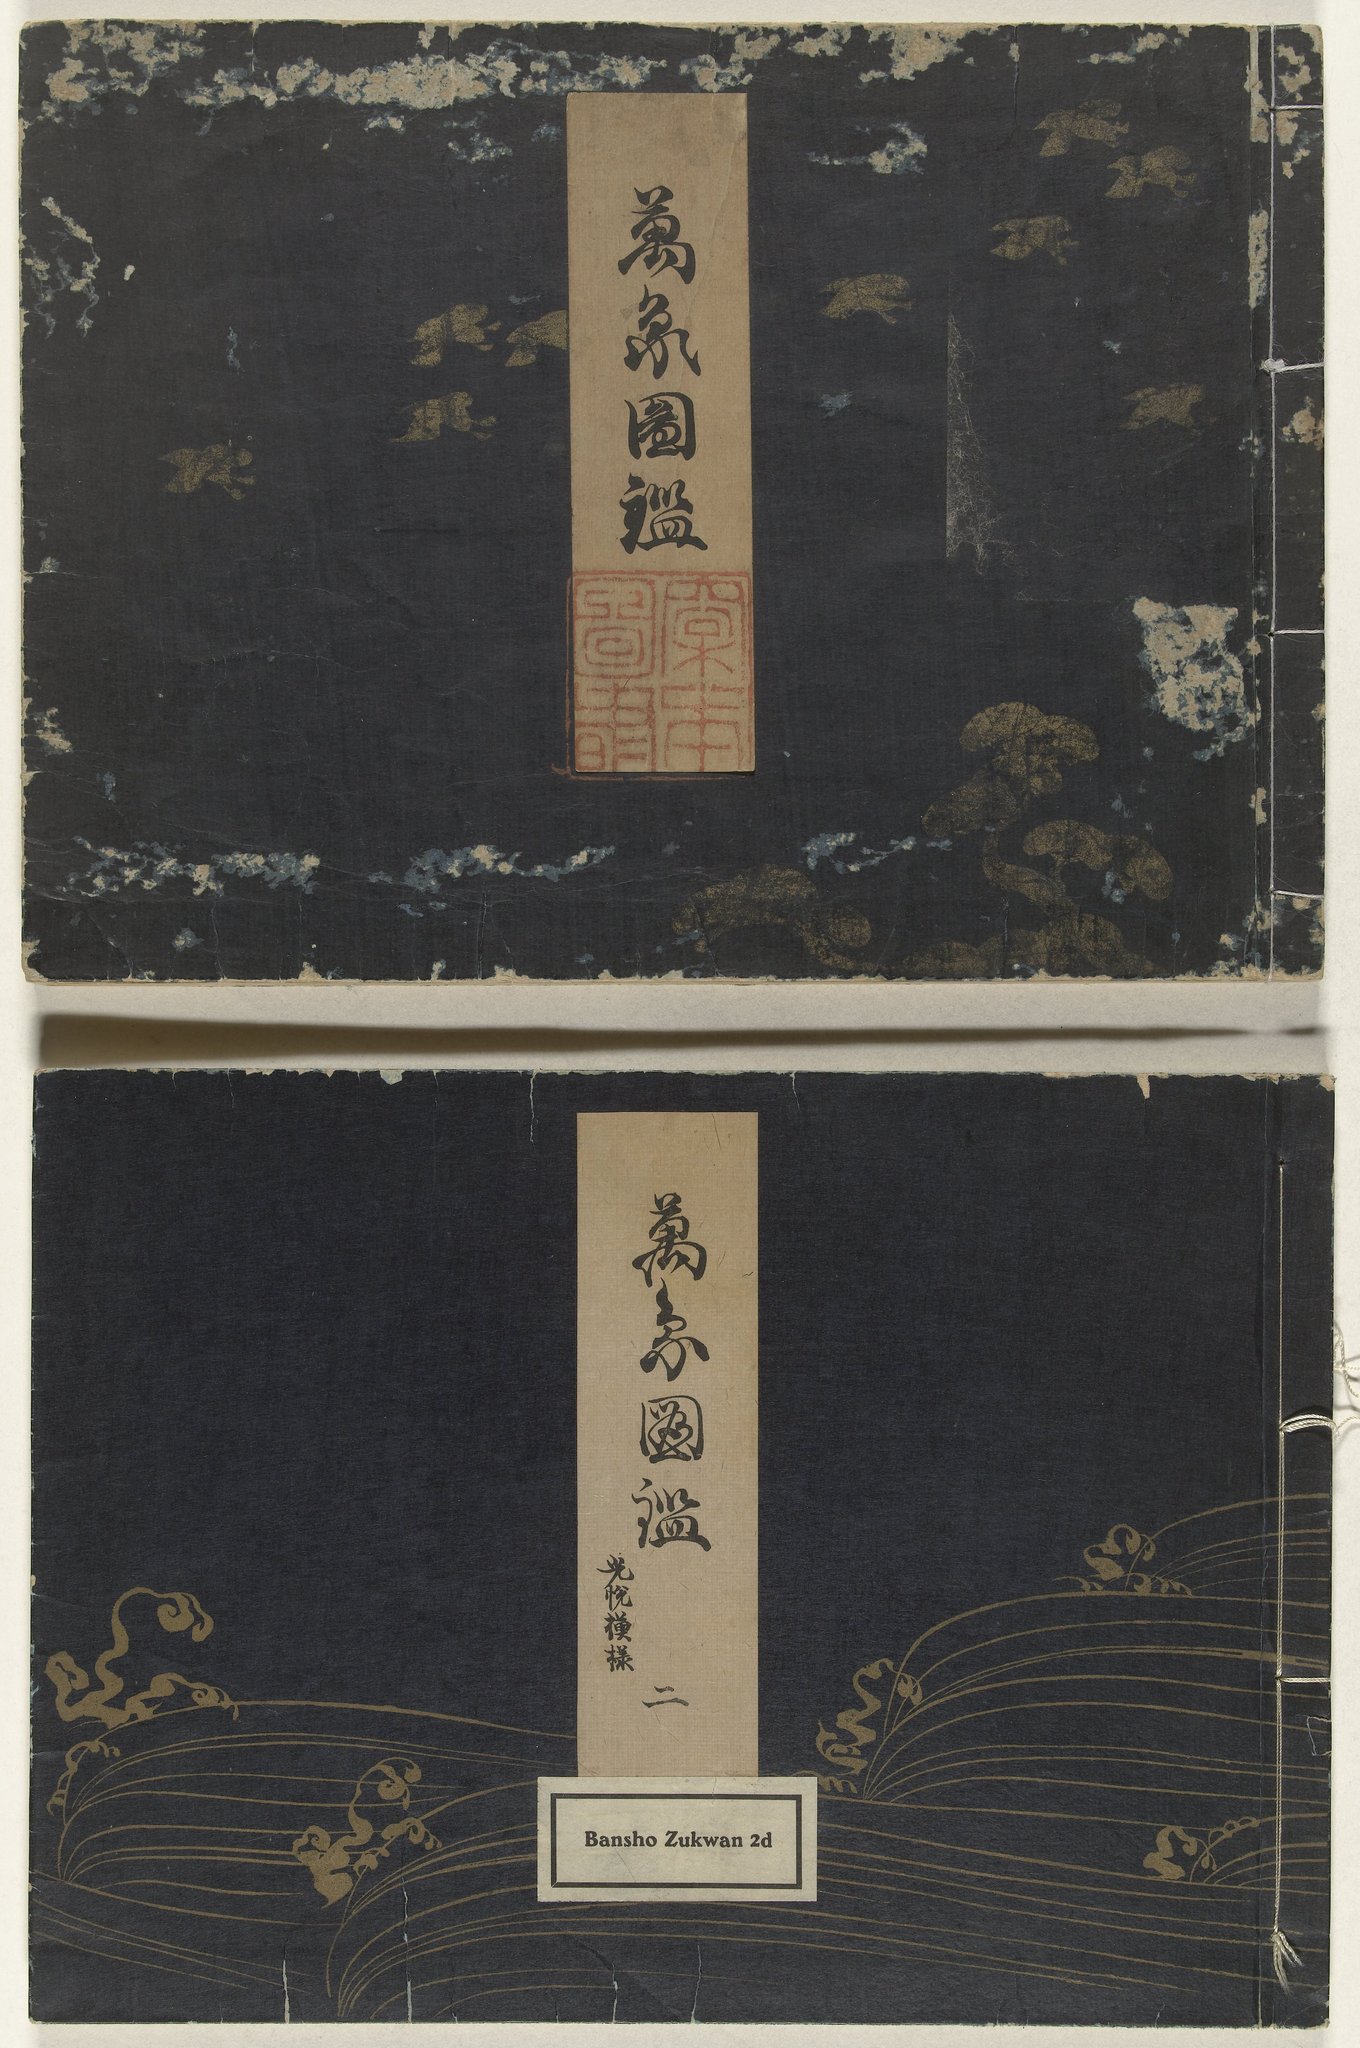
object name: book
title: Prentenboek der natuur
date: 1901-1904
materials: paper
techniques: woodcut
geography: tokyo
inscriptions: date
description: Twee delen (compleet) met afbeeldingen van landschappen, bloemen, planten en dieren. In grijsgroene cassette met golfpatroon.